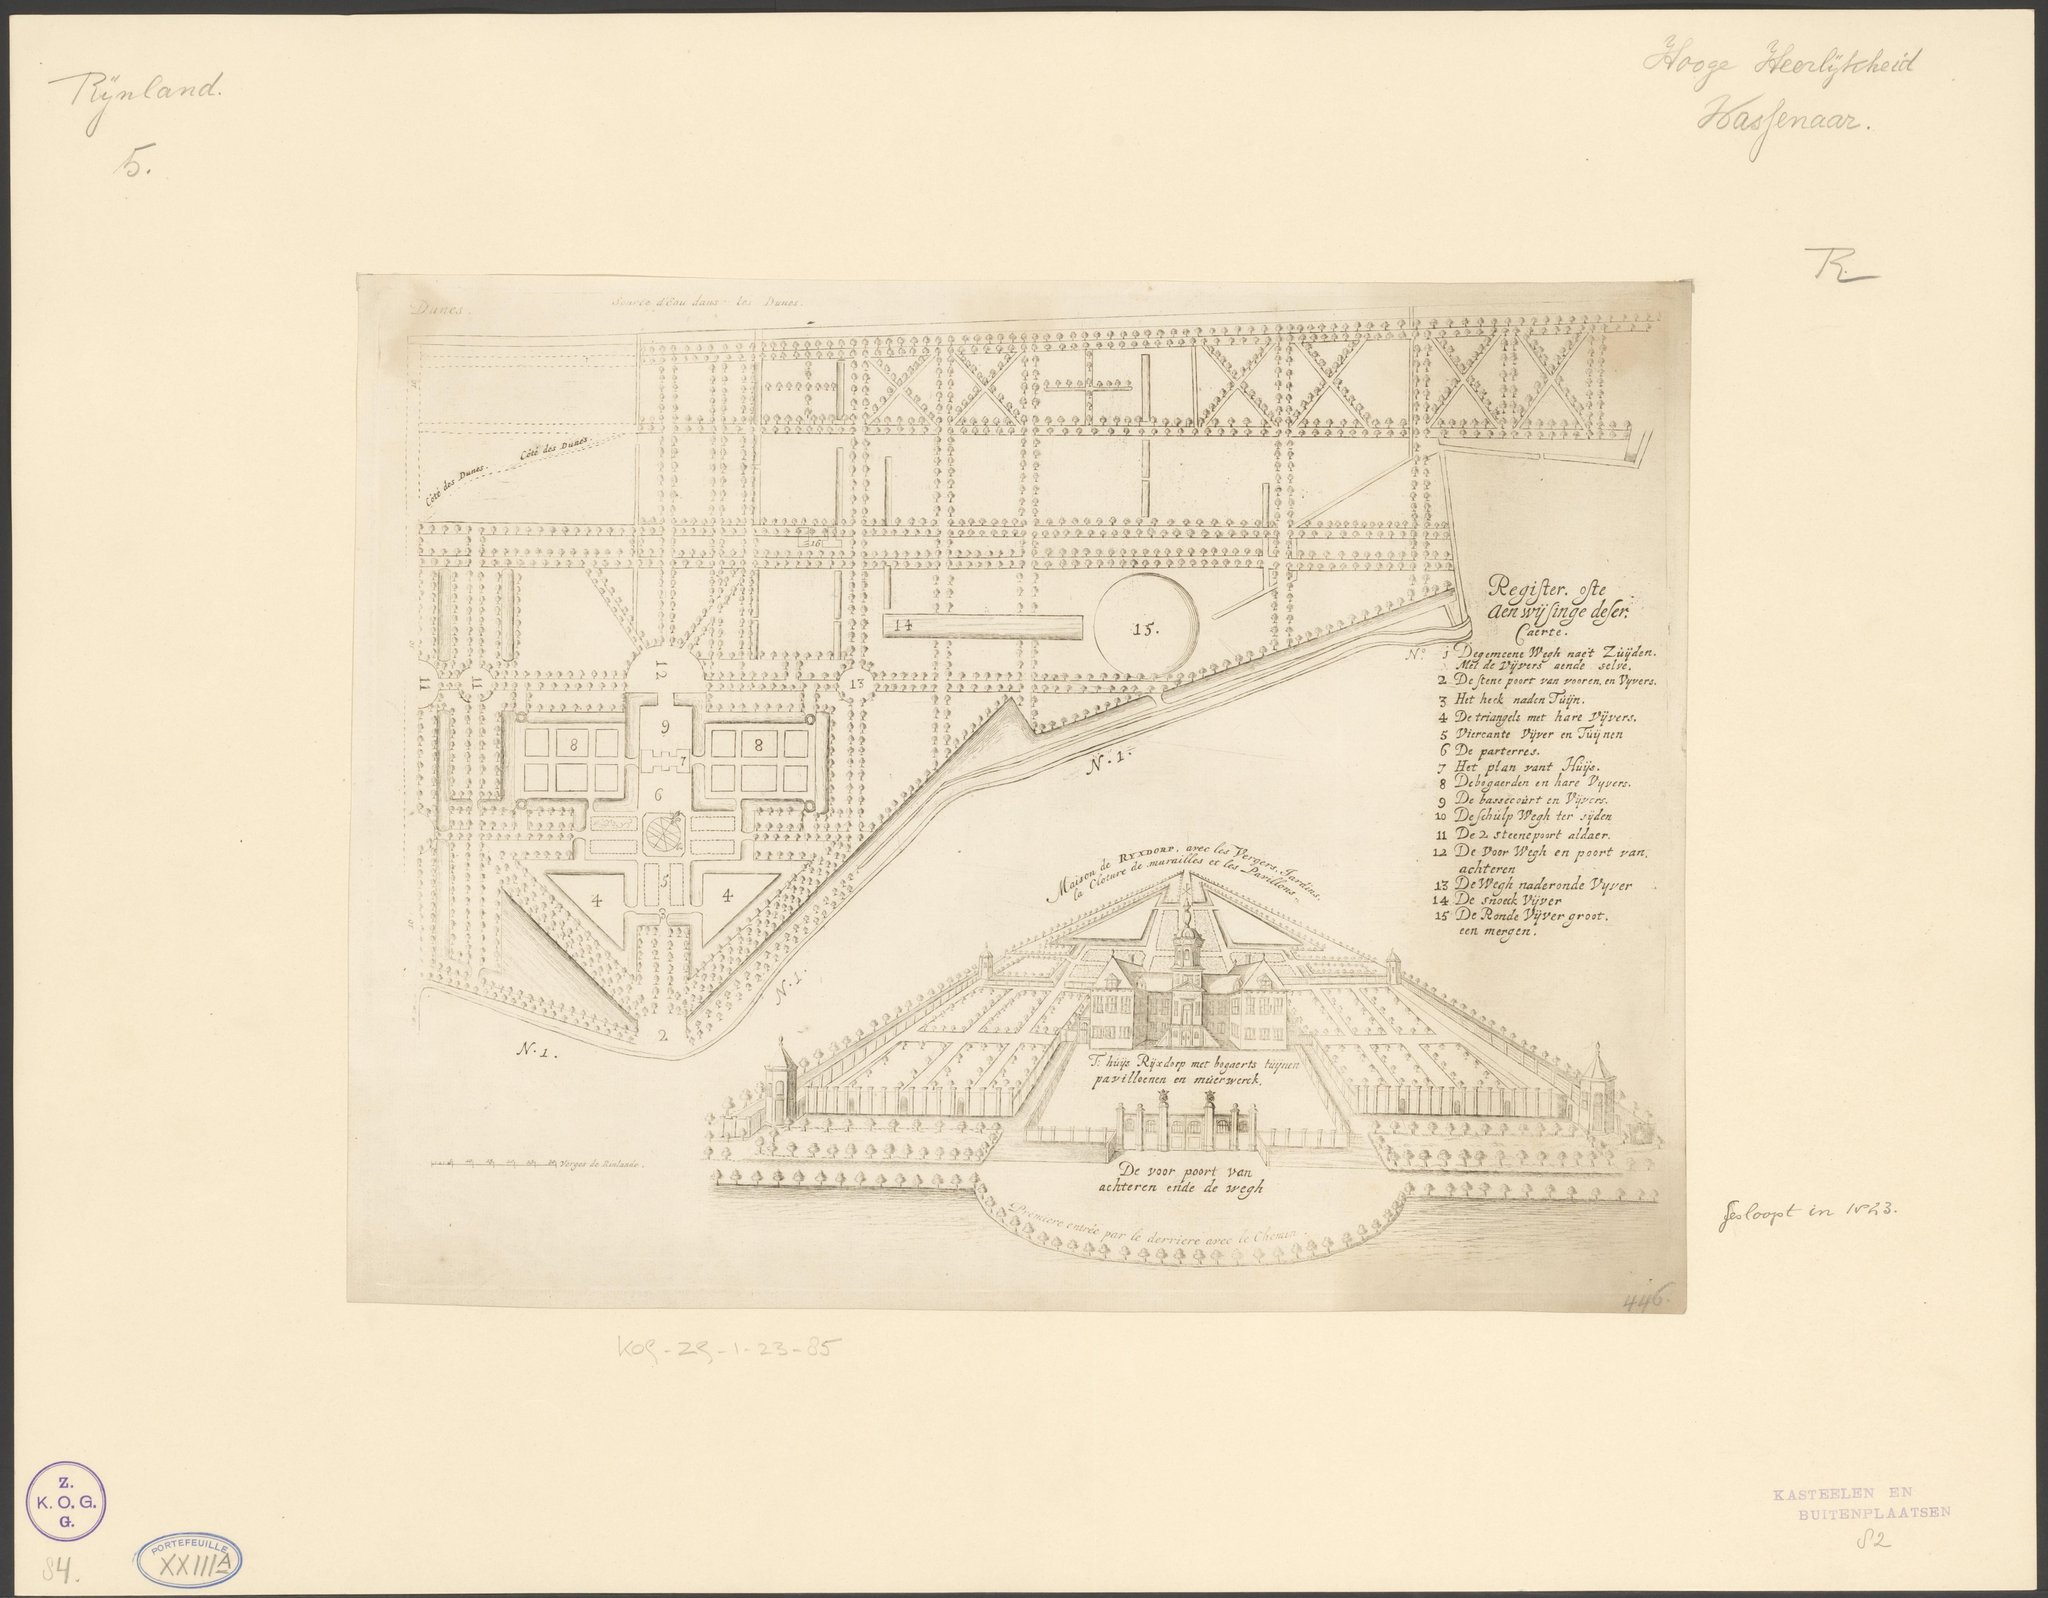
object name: print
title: Gezicht en plattegrond van Landgoed Rijksdorp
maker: Anonymous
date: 1700-1799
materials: paper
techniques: engraving, etching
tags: french or architectonic garden; formal garden, bird's eye view ~ representation of building, country-house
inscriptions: stamp, stamp, collector's mark: Lugt 1641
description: Gezicht en plattegrond van Landgoed Rijksdorp. Rechts een legenda van 1-15. Linksonder de schaalverdeling. Onderwerpsrubrieken binnen de Atlas Zeden en Gewoonten: Zeden en Gewoonten in Engeren Zin, De Woning. Kastelen en buitenplaatsen. Holland.